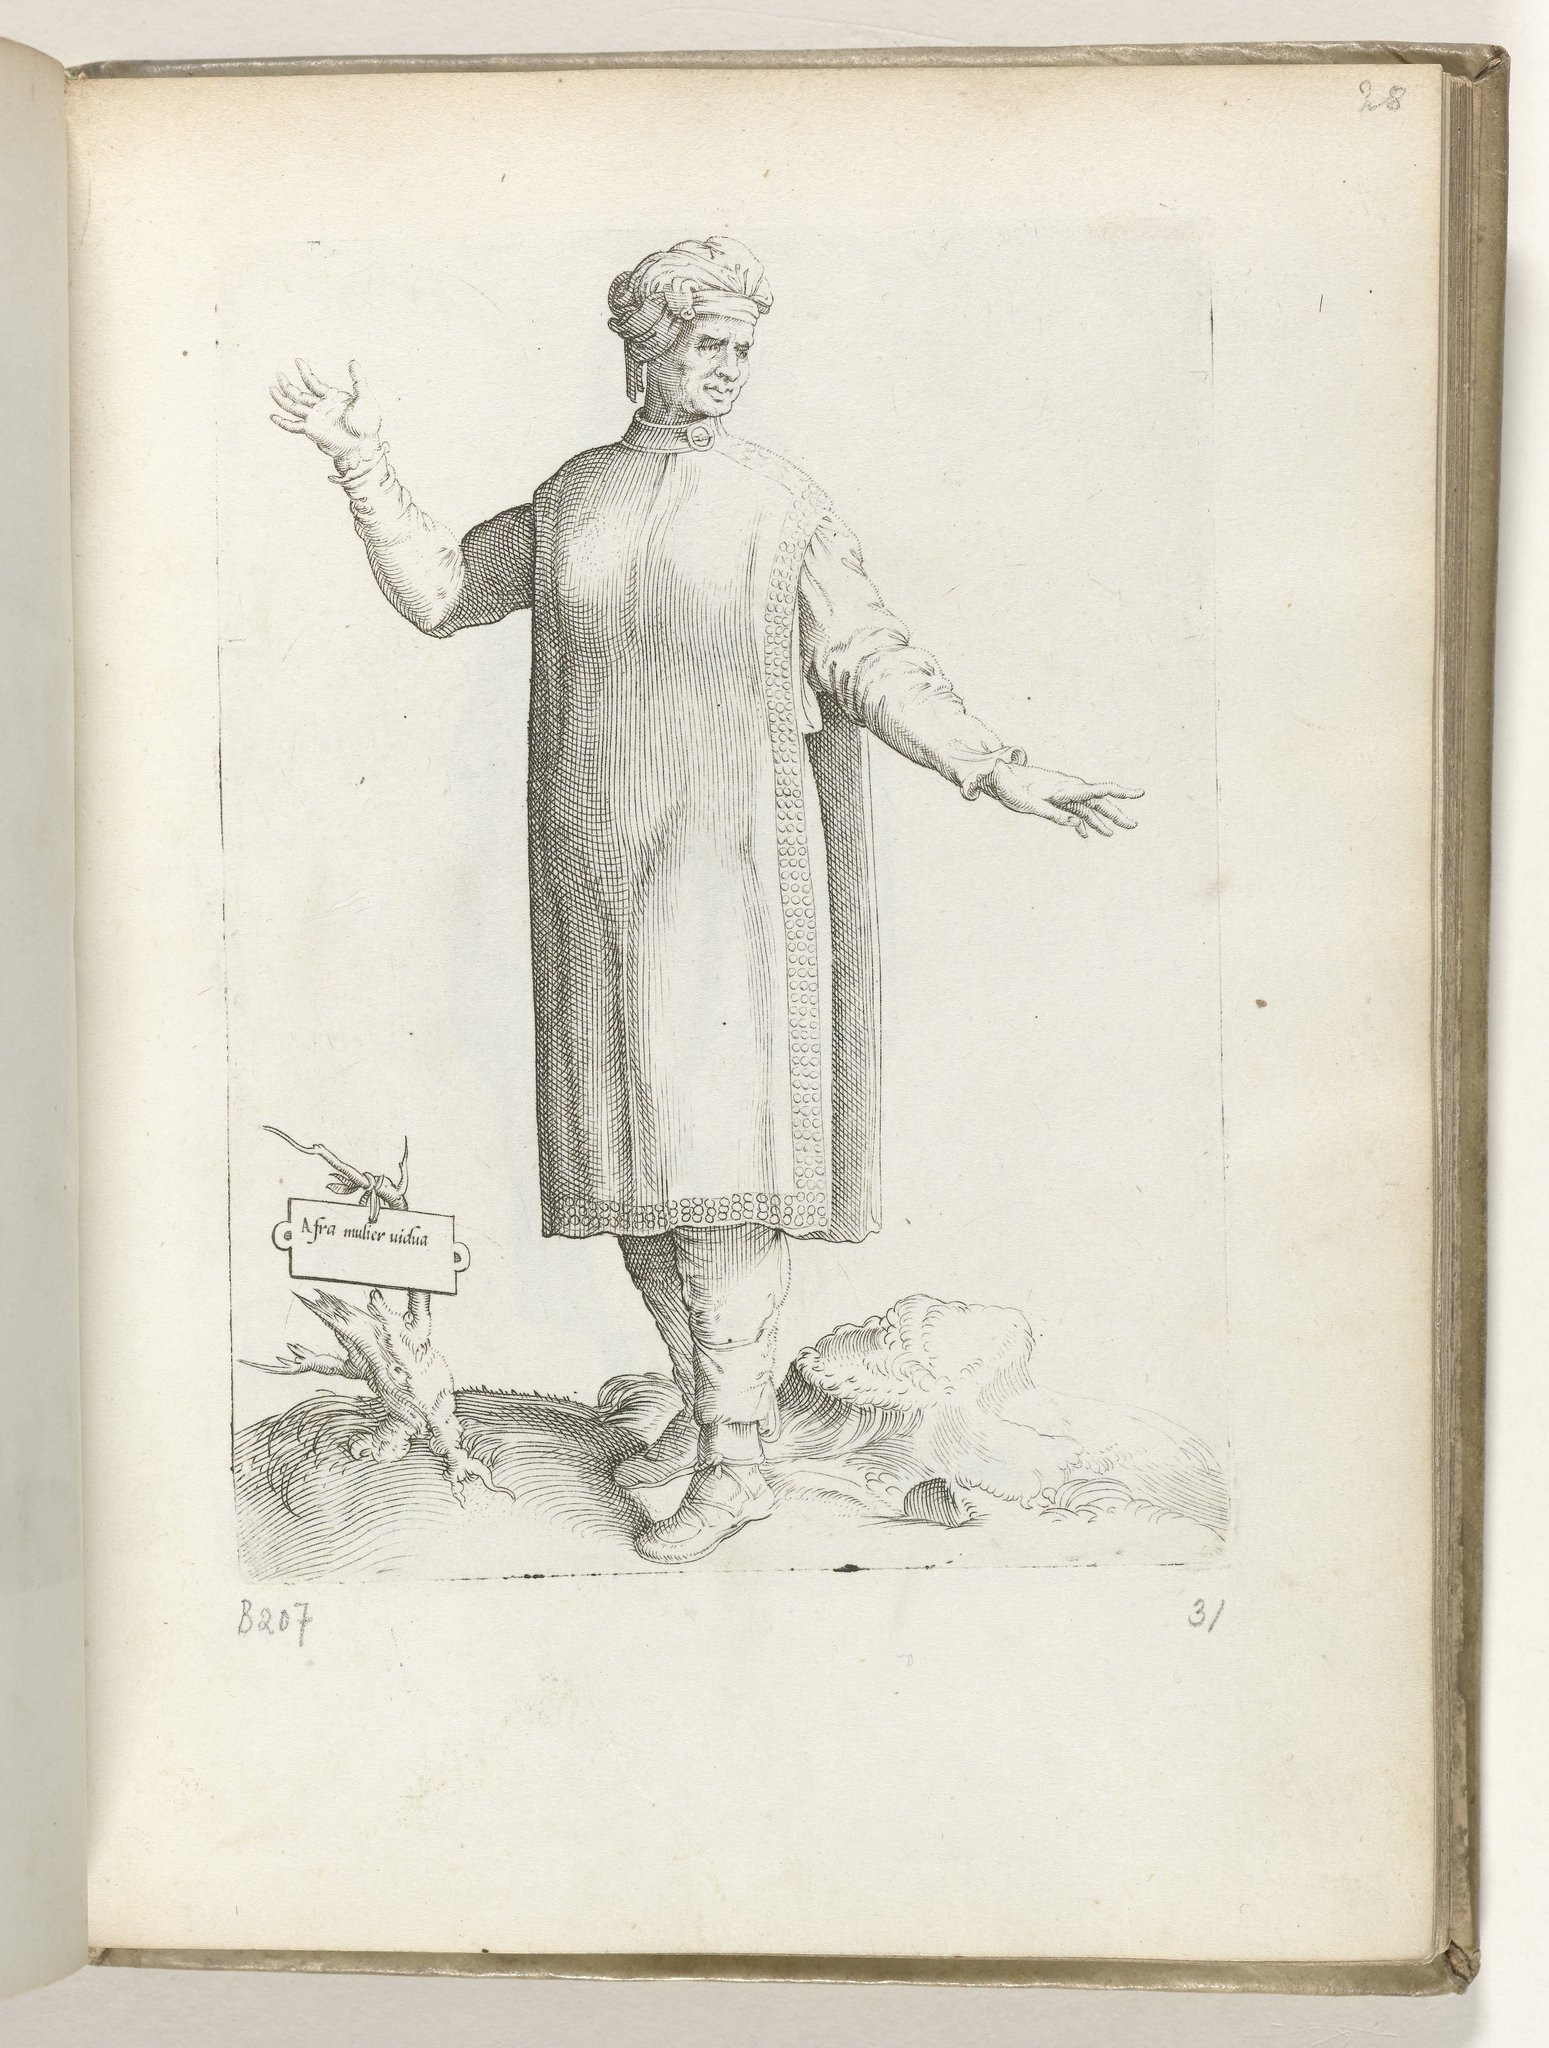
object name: costume print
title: Diversarum gentium nostrae aetatis habitus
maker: enea vico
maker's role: draughtsman, print maker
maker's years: 1523-1567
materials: paper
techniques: engraving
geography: venice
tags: africans (+ costume), fashion plates, widow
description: Prent uit album 'Diversarum gentium nostrae aetatis habitus'.